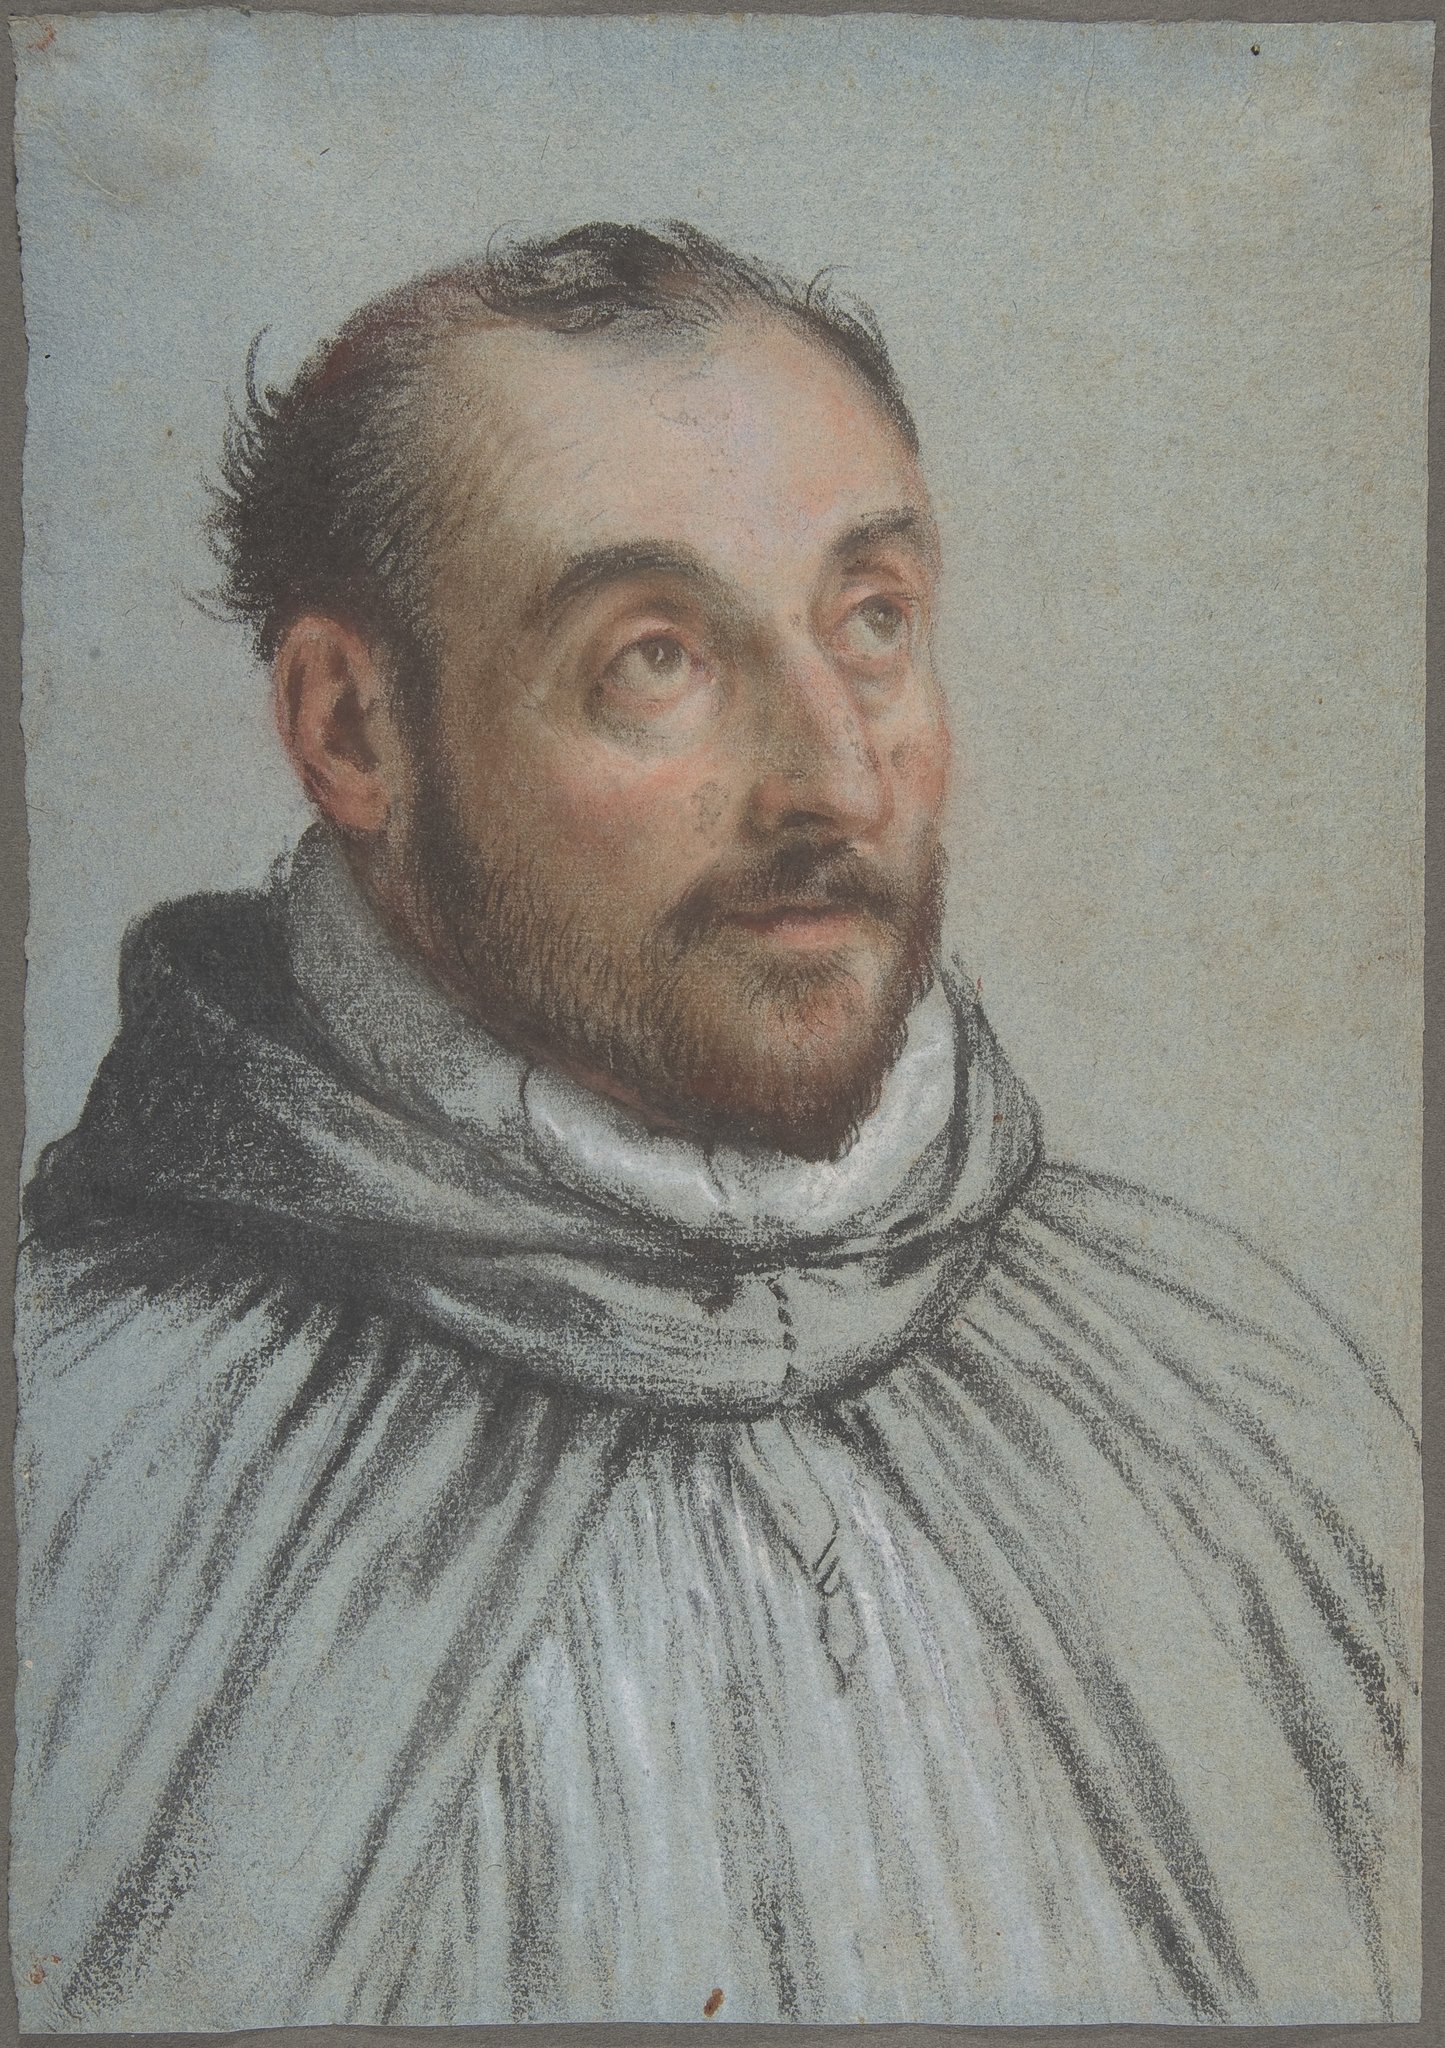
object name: drawing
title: Bust-Length Portrait of an Ecclesiastic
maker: carletto caliari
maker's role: artist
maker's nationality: italian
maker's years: 1567-1596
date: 1501-1600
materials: chalk, charcoal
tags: men,portraits